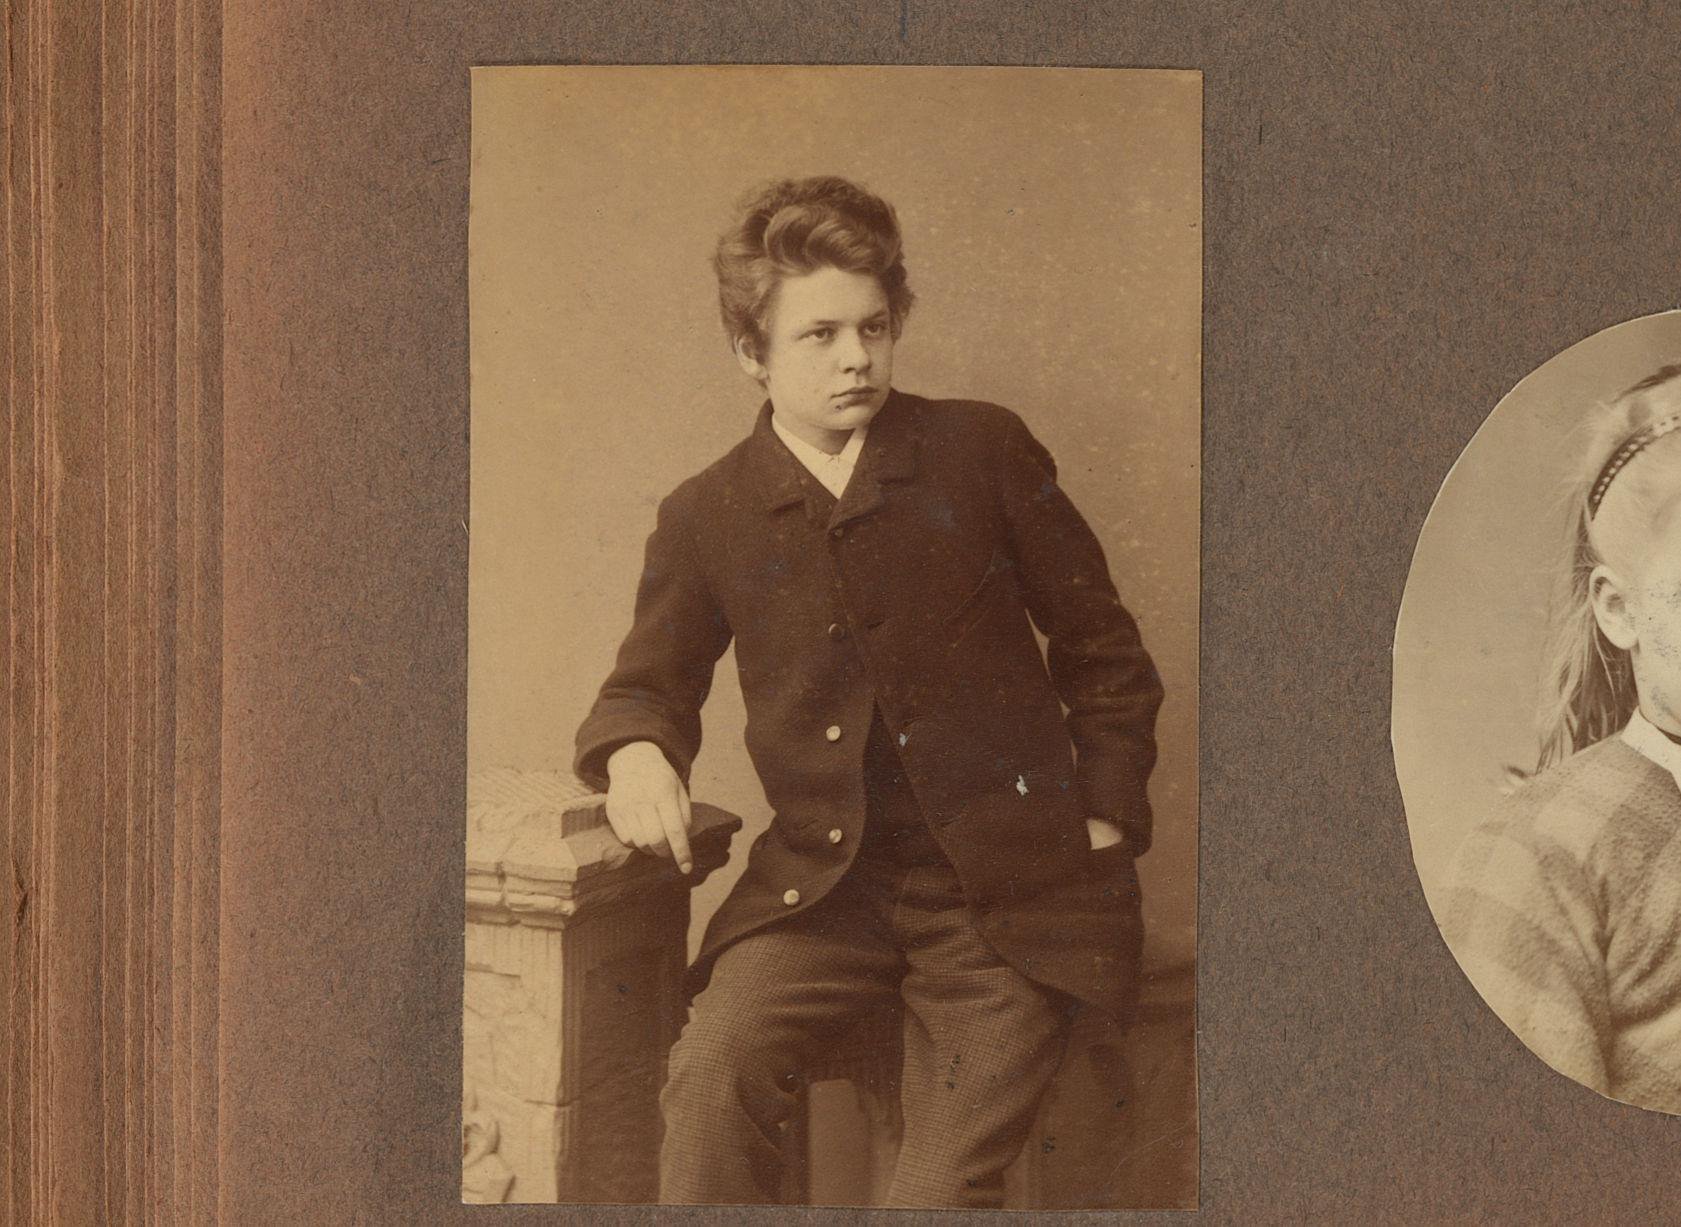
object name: photograph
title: Portret van staande jonge man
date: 1870-1910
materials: photographic support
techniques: photography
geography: amsterdam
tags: netherlands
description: Foto op bruin albumblad 30 van familiealbum van Alphons Diepenbrock.